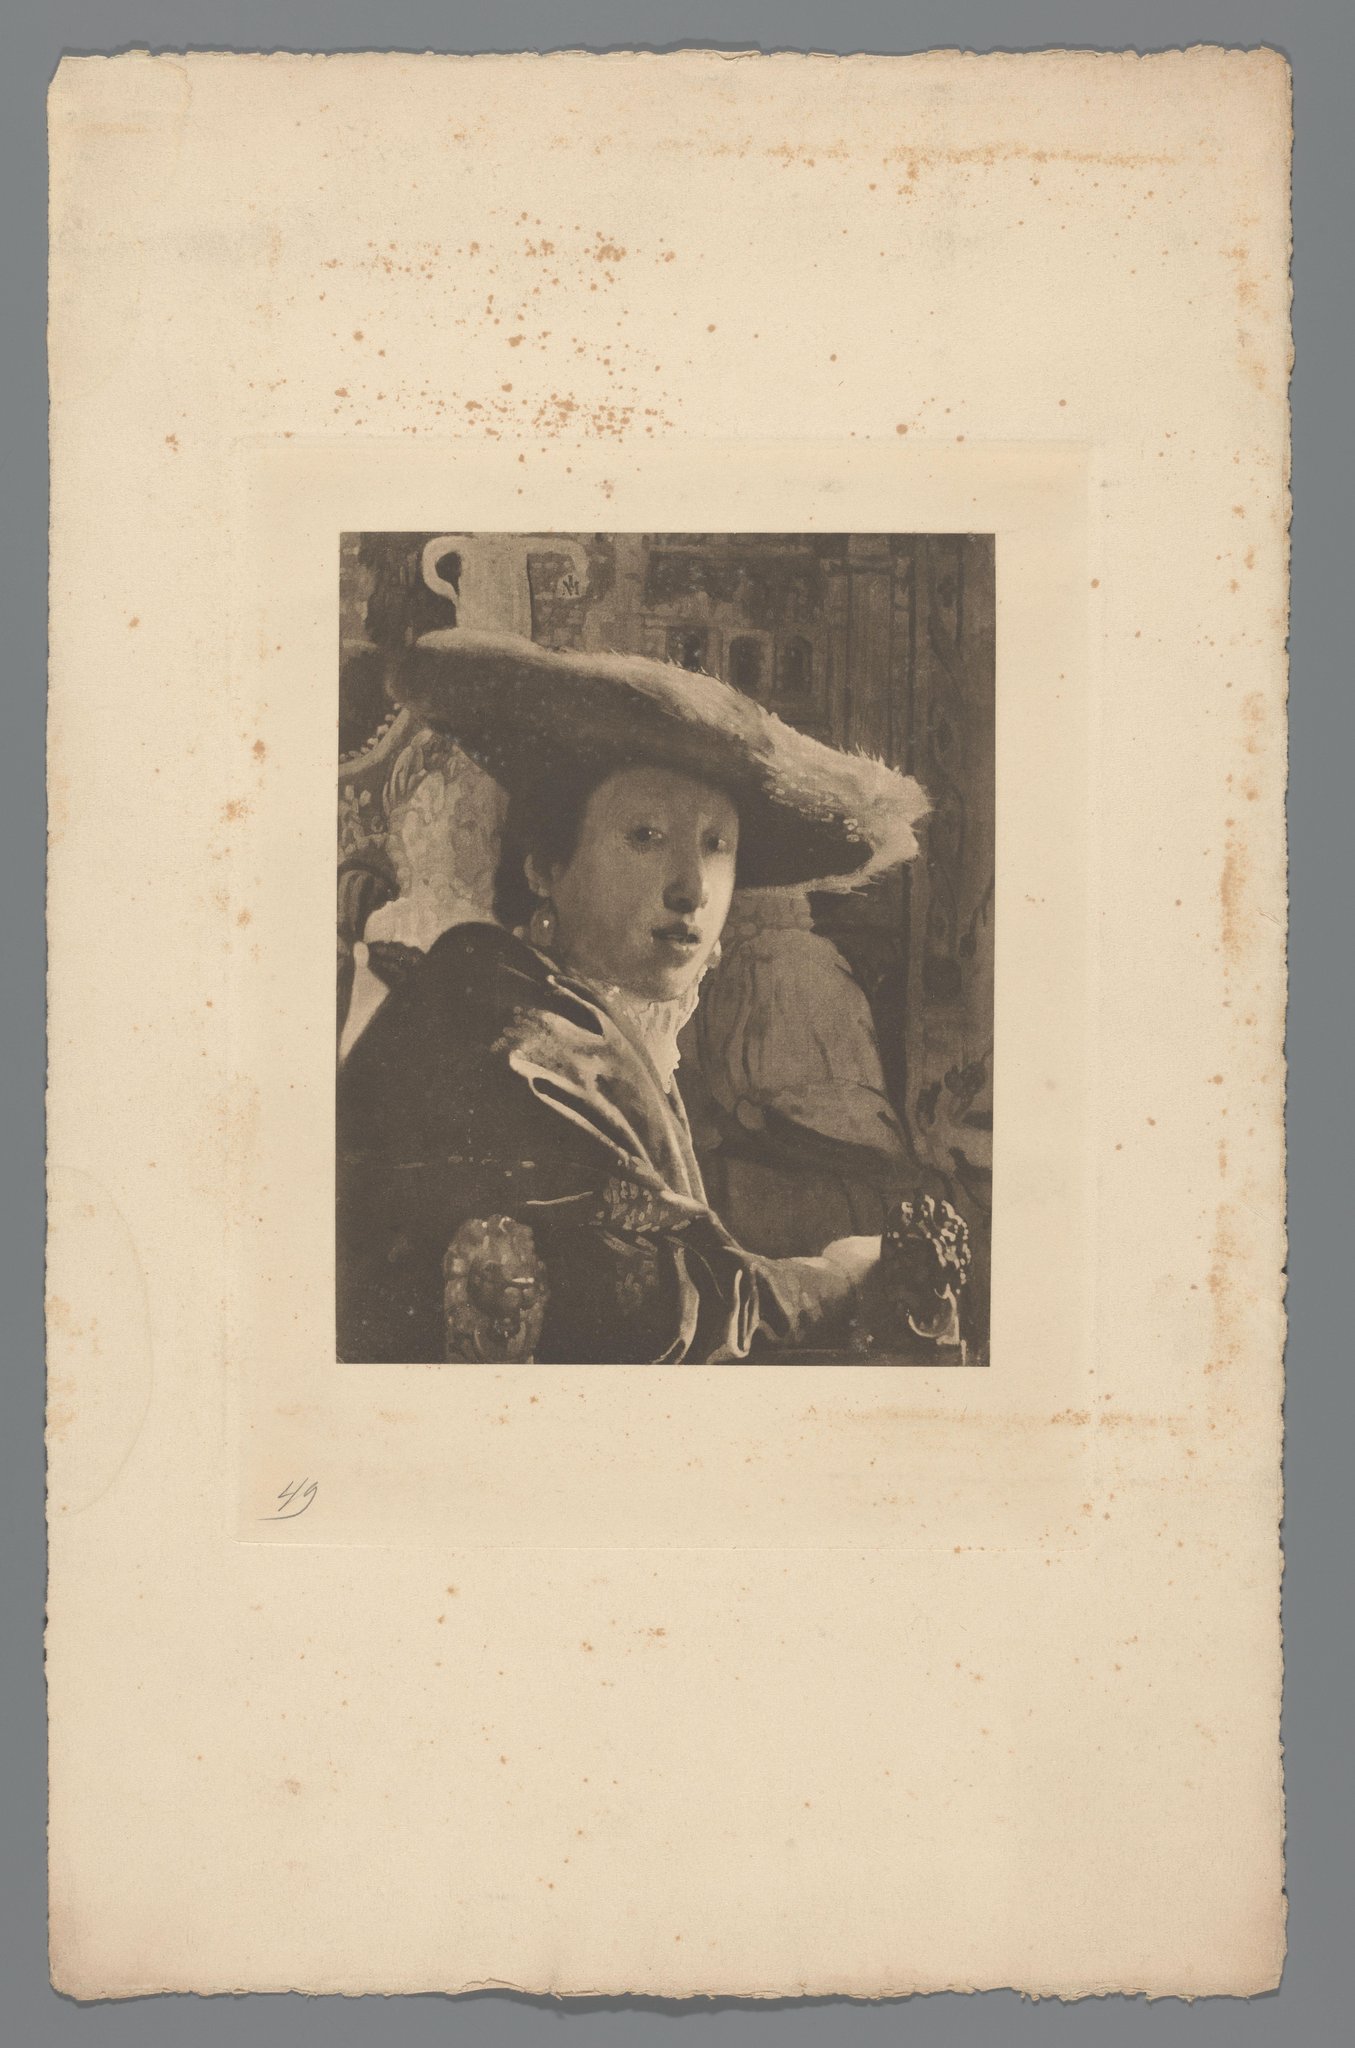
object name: reproduction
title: Reproductie van het schilderij Meisje met de rode hoed door Johannes Vermeer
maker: Anonymous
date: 1880-2023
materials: paper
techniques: photoaquatint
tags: adolescent, young woman, maiden, head-gear, anonymous historical person portrayed alone - bb - woman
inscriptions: number: ‘49’